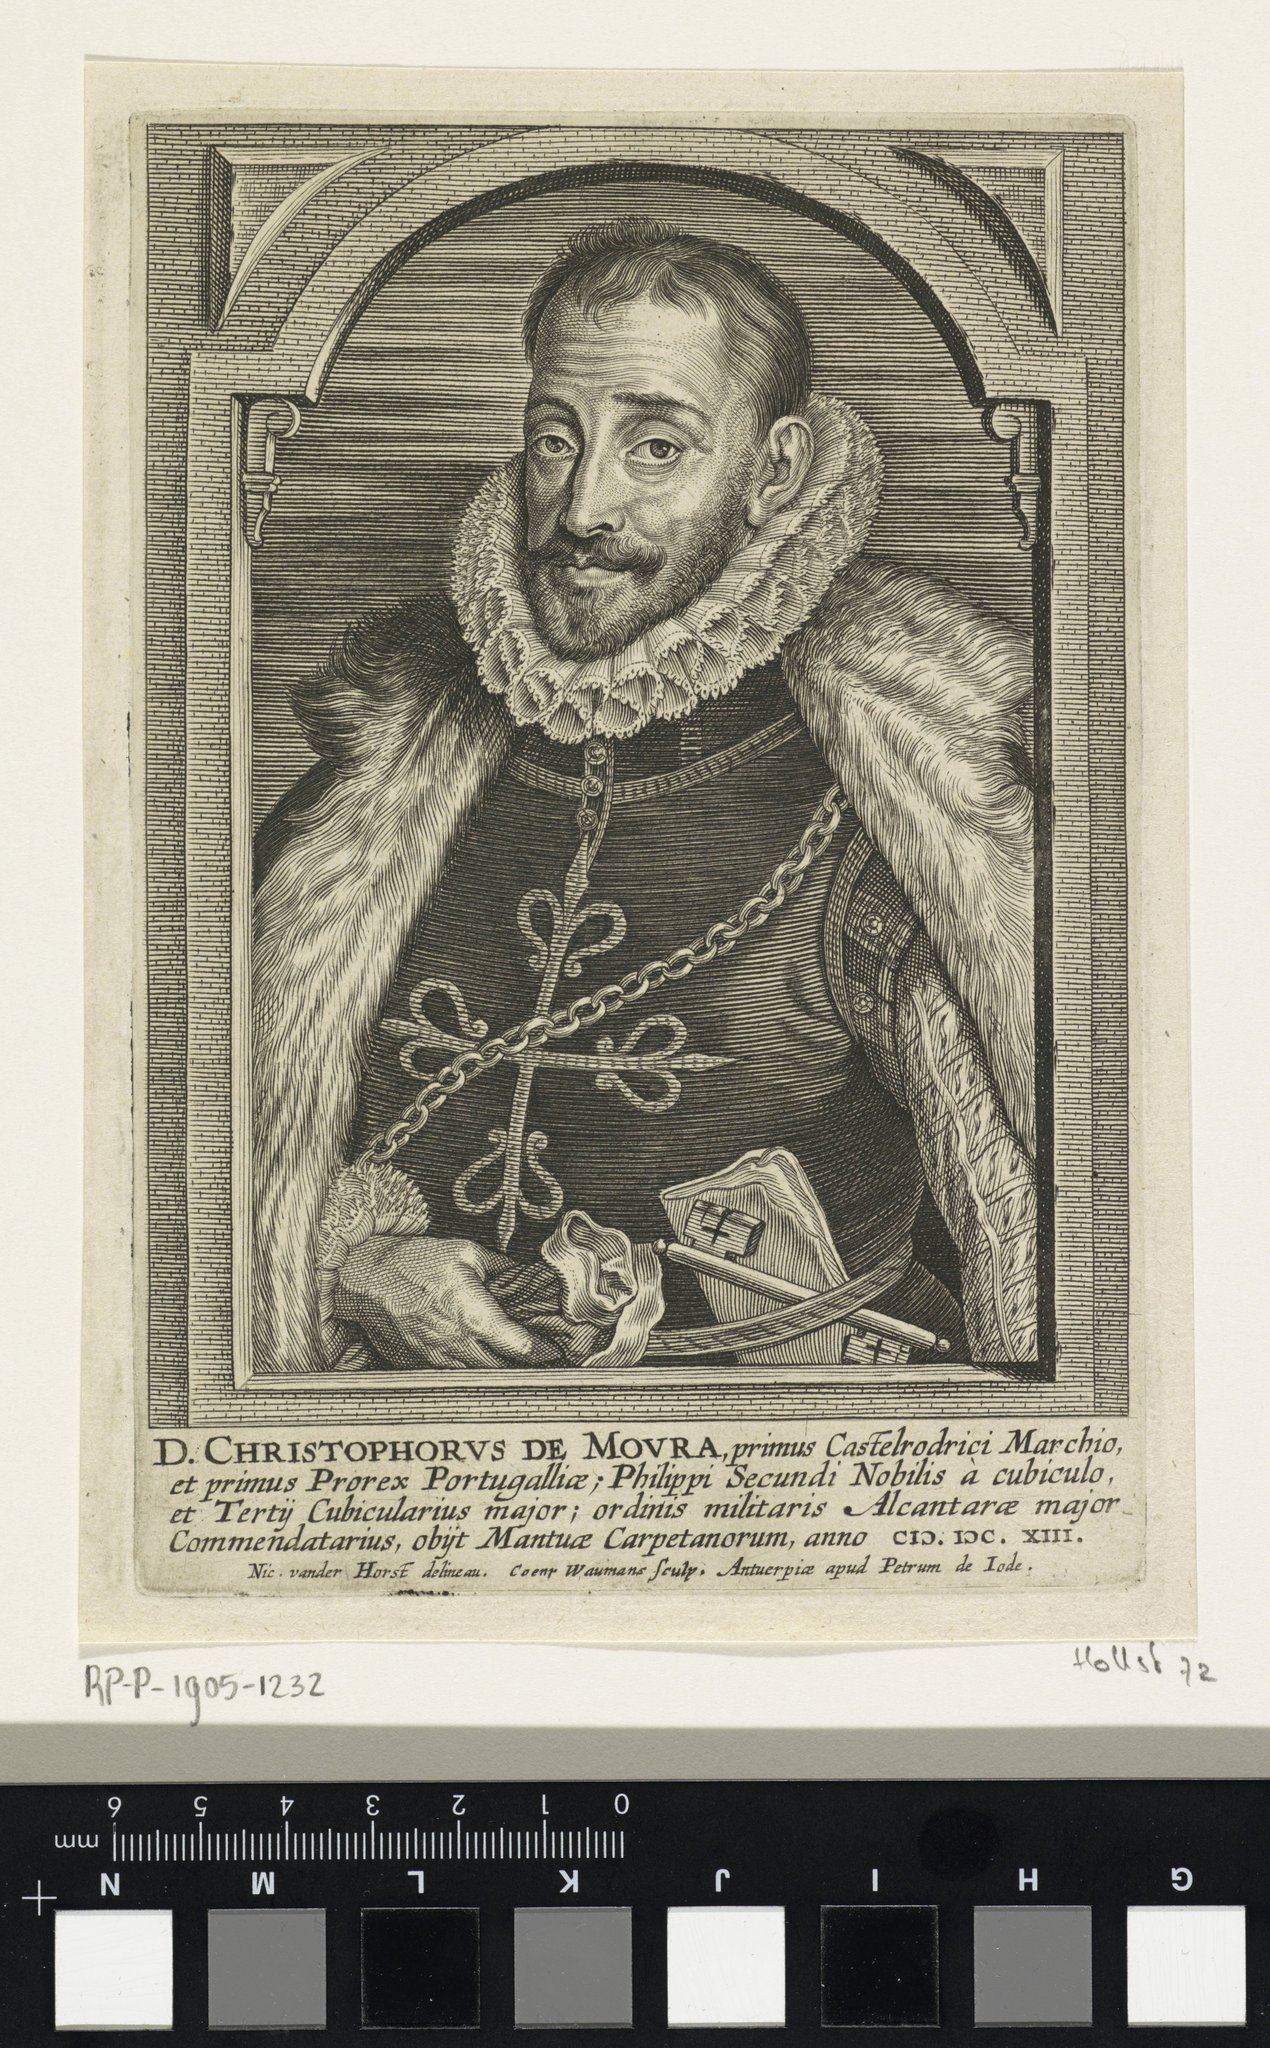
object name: print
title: Portret van Christopher de Moura, markies van Castel Rodrigo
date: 1633-1673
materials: paper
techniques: engraving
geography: antwerp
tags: lissabon, christopher de moura markies van castel rodrigo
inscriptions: collector's mark: Lugt 2228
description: Portret van Christopher de Moura, markies van Castel Rodrigo. In de marge een vierregelig onderschrift in het Latijn.